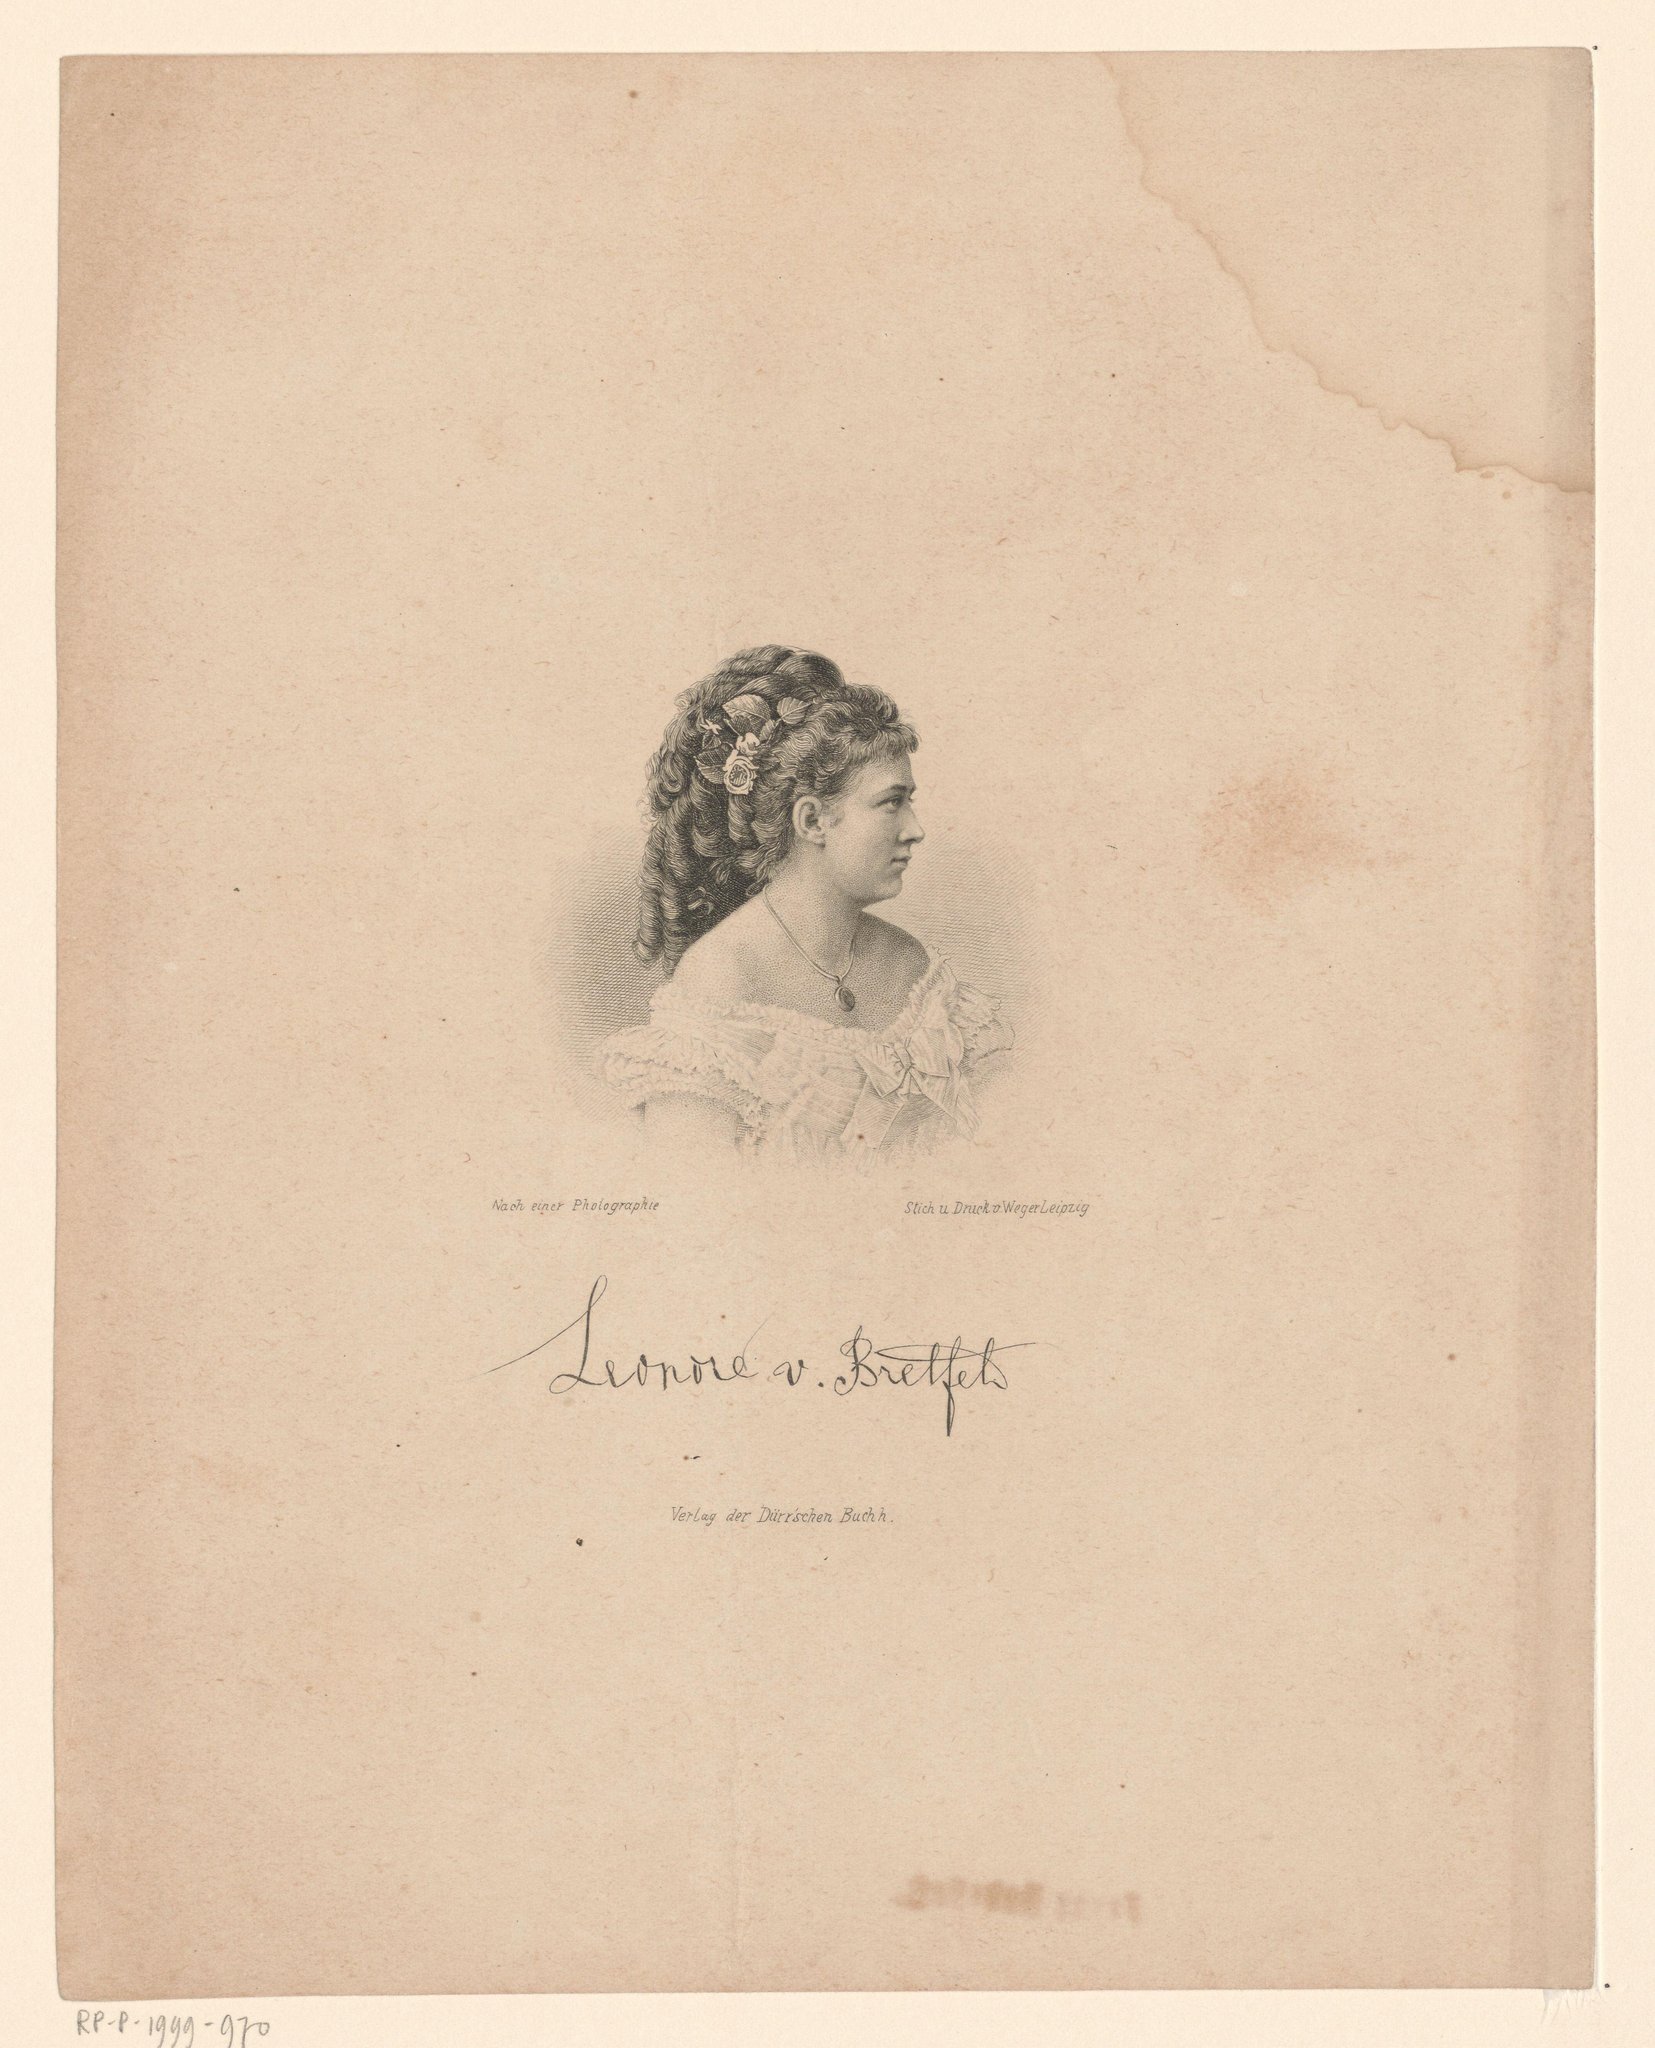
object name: print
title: Portret van Leonore von Brelfeld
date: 1840-1892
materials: paper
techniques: engraving, etching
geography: leipzig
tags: historical persons - bb - woman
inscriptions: collector's mark: ‘Franz Radestadt’, collector's mark: Lugt 2228, collector's mark: Lugt 2760